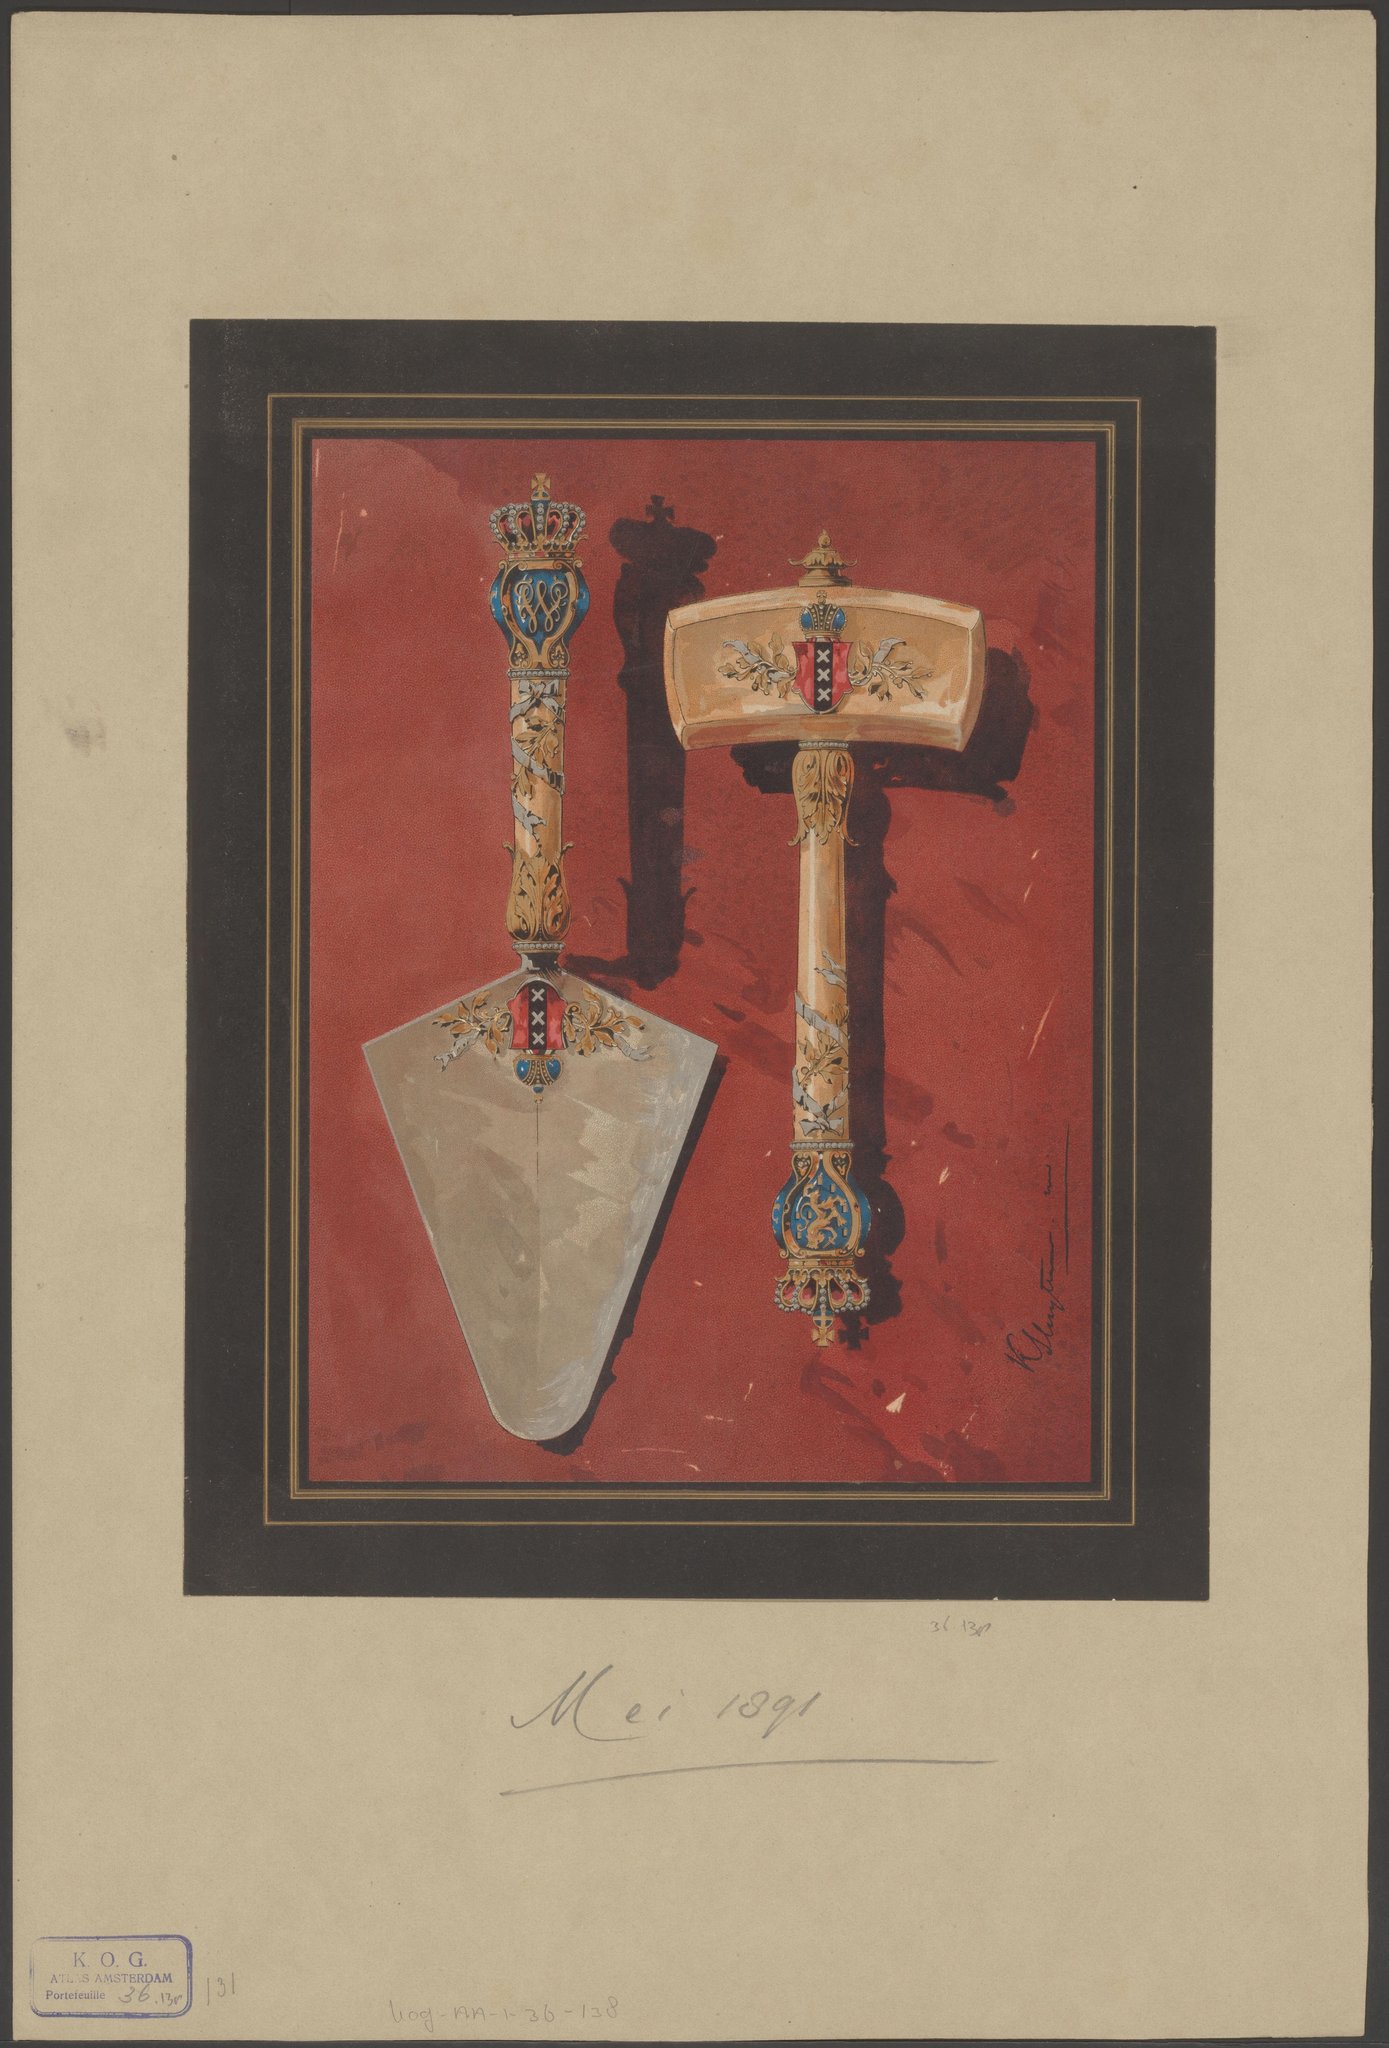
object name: print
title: Troffel en hamer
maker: karel sluijterman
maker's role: designer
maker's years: 1863-1931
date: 1805-1891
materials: paper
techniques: chromolithography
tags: tools, aids, implements ~ crafts and industries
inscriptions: collector's mark: Lugt 1641b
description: Troffel en hamer met het wapen van Amsterdam. Waarschijnlijk gebruikt bij de eerstesteenlegging van het Wilhelmina Gasthuis. Onderwerpsrubriek binnen de Atlas Amsterdam: Armwezen en liefdadige instellingen: I. Stadsinrichtingen: Wilhelminagasthuis.